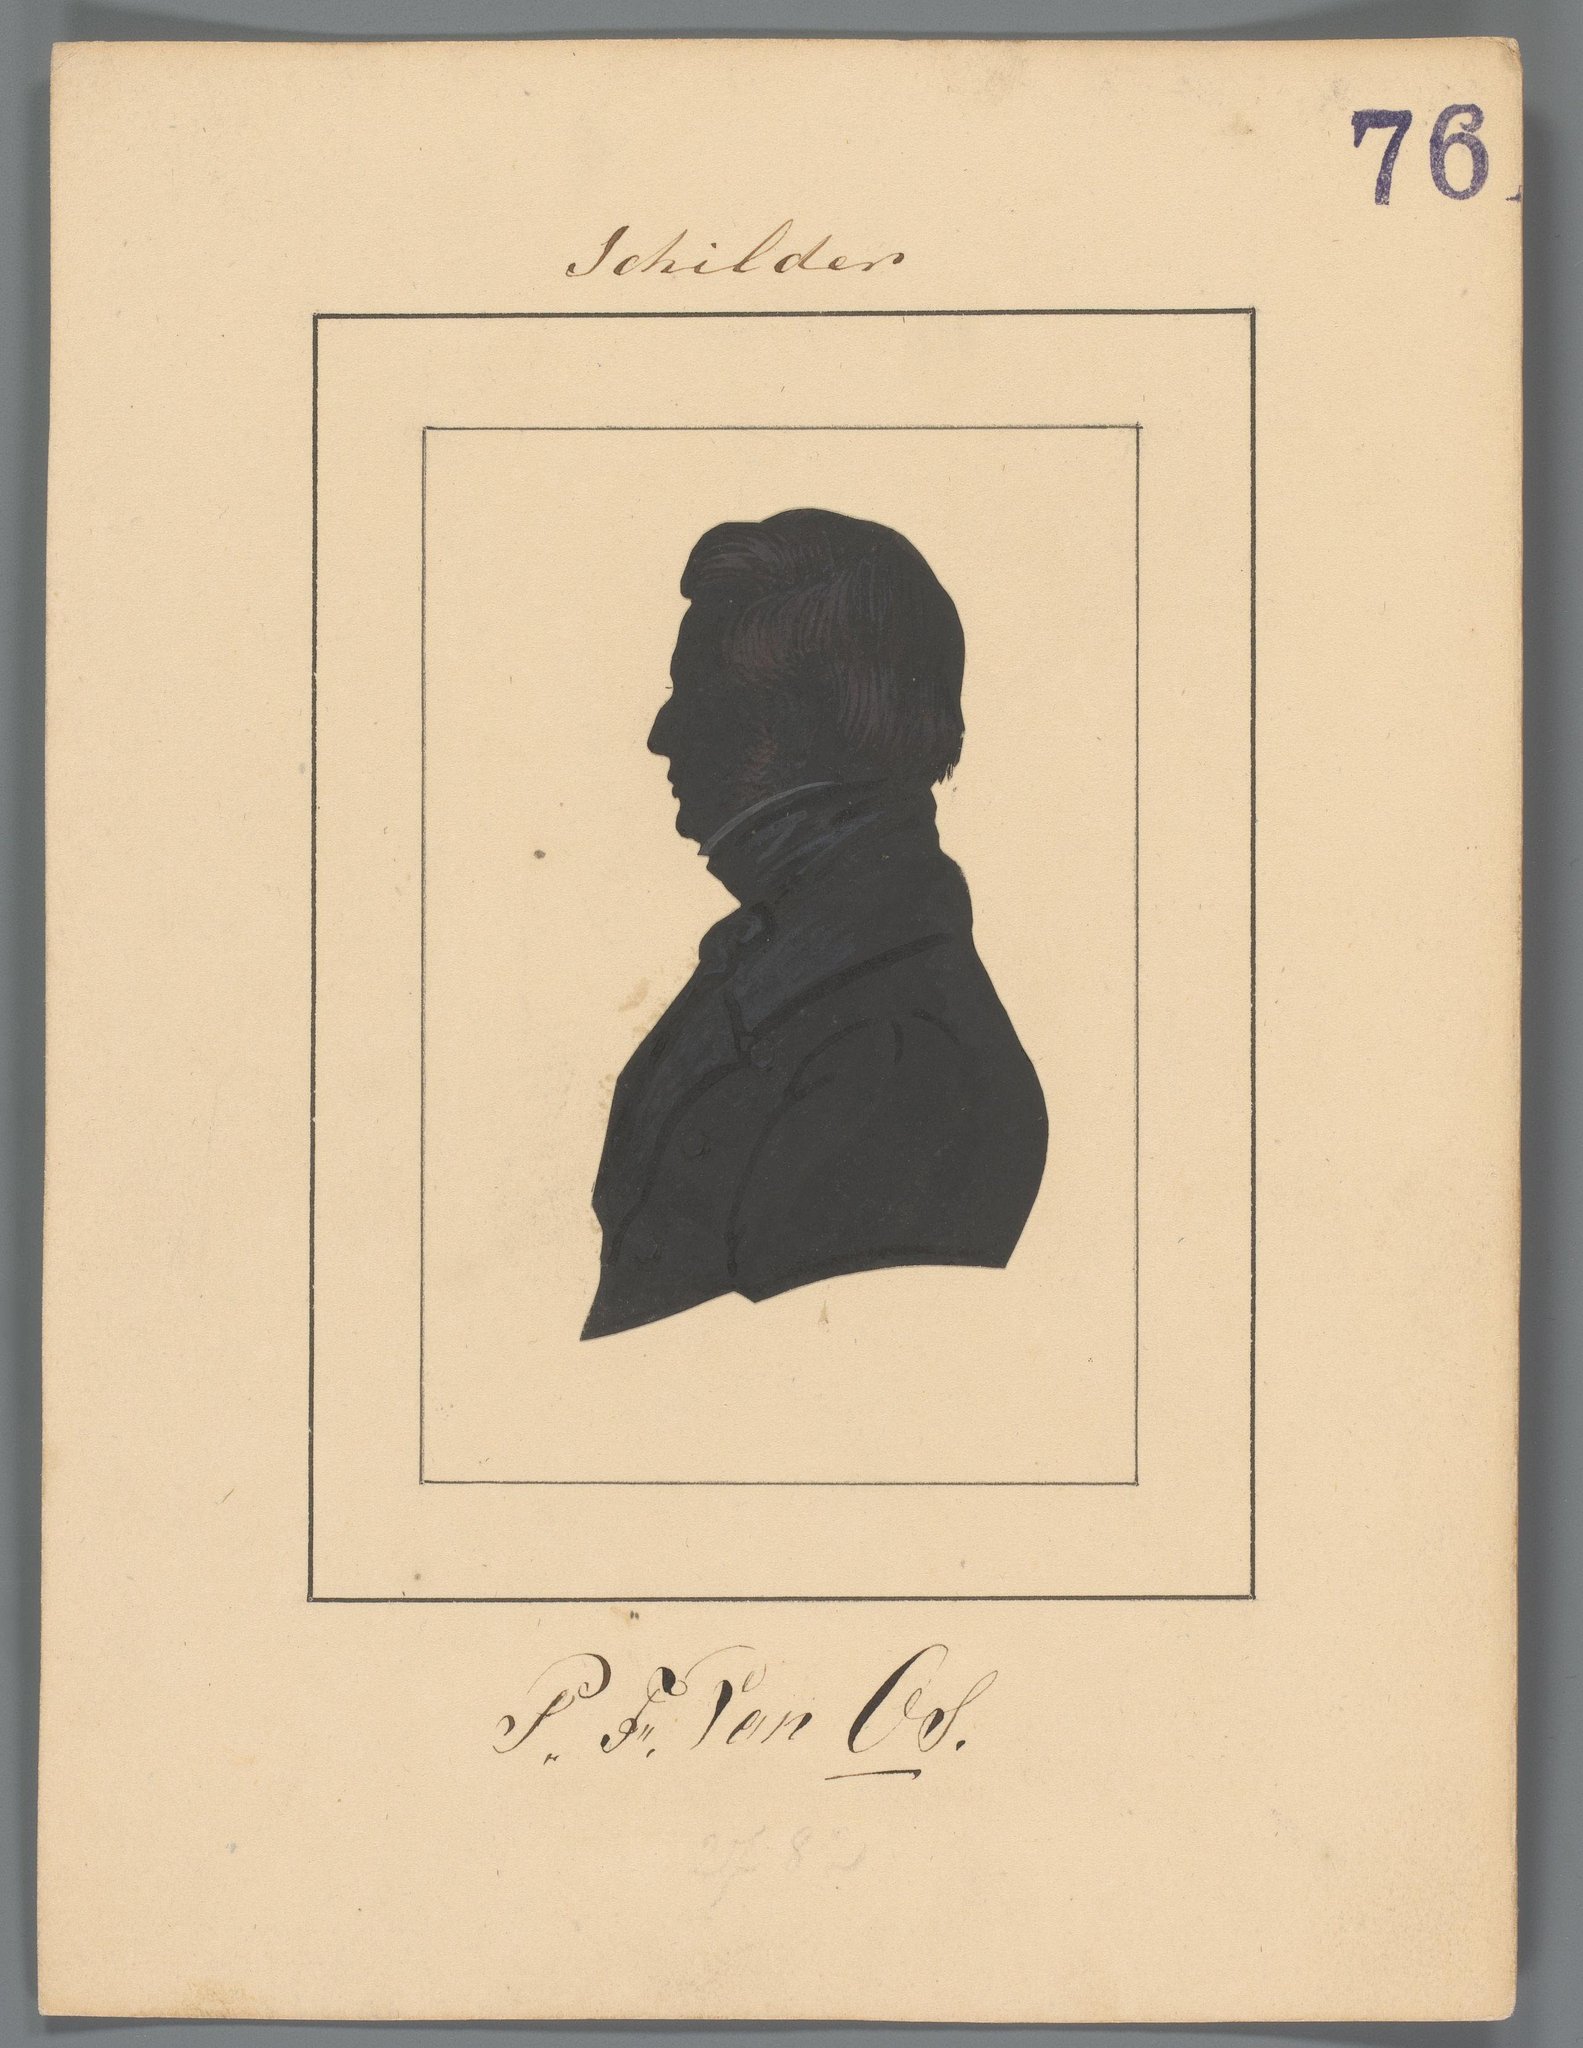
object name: cut paper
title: Silhouetportret van Pieter Frederik van Os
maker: elisabeth alida haanen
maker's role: draughtsman, print maker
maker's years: 1809-1845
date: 1819-1845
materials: ink, paint, paper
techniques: brush, snipping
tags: haarlem, pieter frederik van os, historical persons, portrait, self-portrait of painter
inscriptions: number: ‘76’, inscription: ‘Schilder’, collector's mark: ‘Ex-libris van Beresteyn’, inscription: ‘P.F. Van Os.’, inscription: ‘Neg. D. 1790’, number: ‘14002’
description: Met onder het portret de handtekening van de geportretteerde.